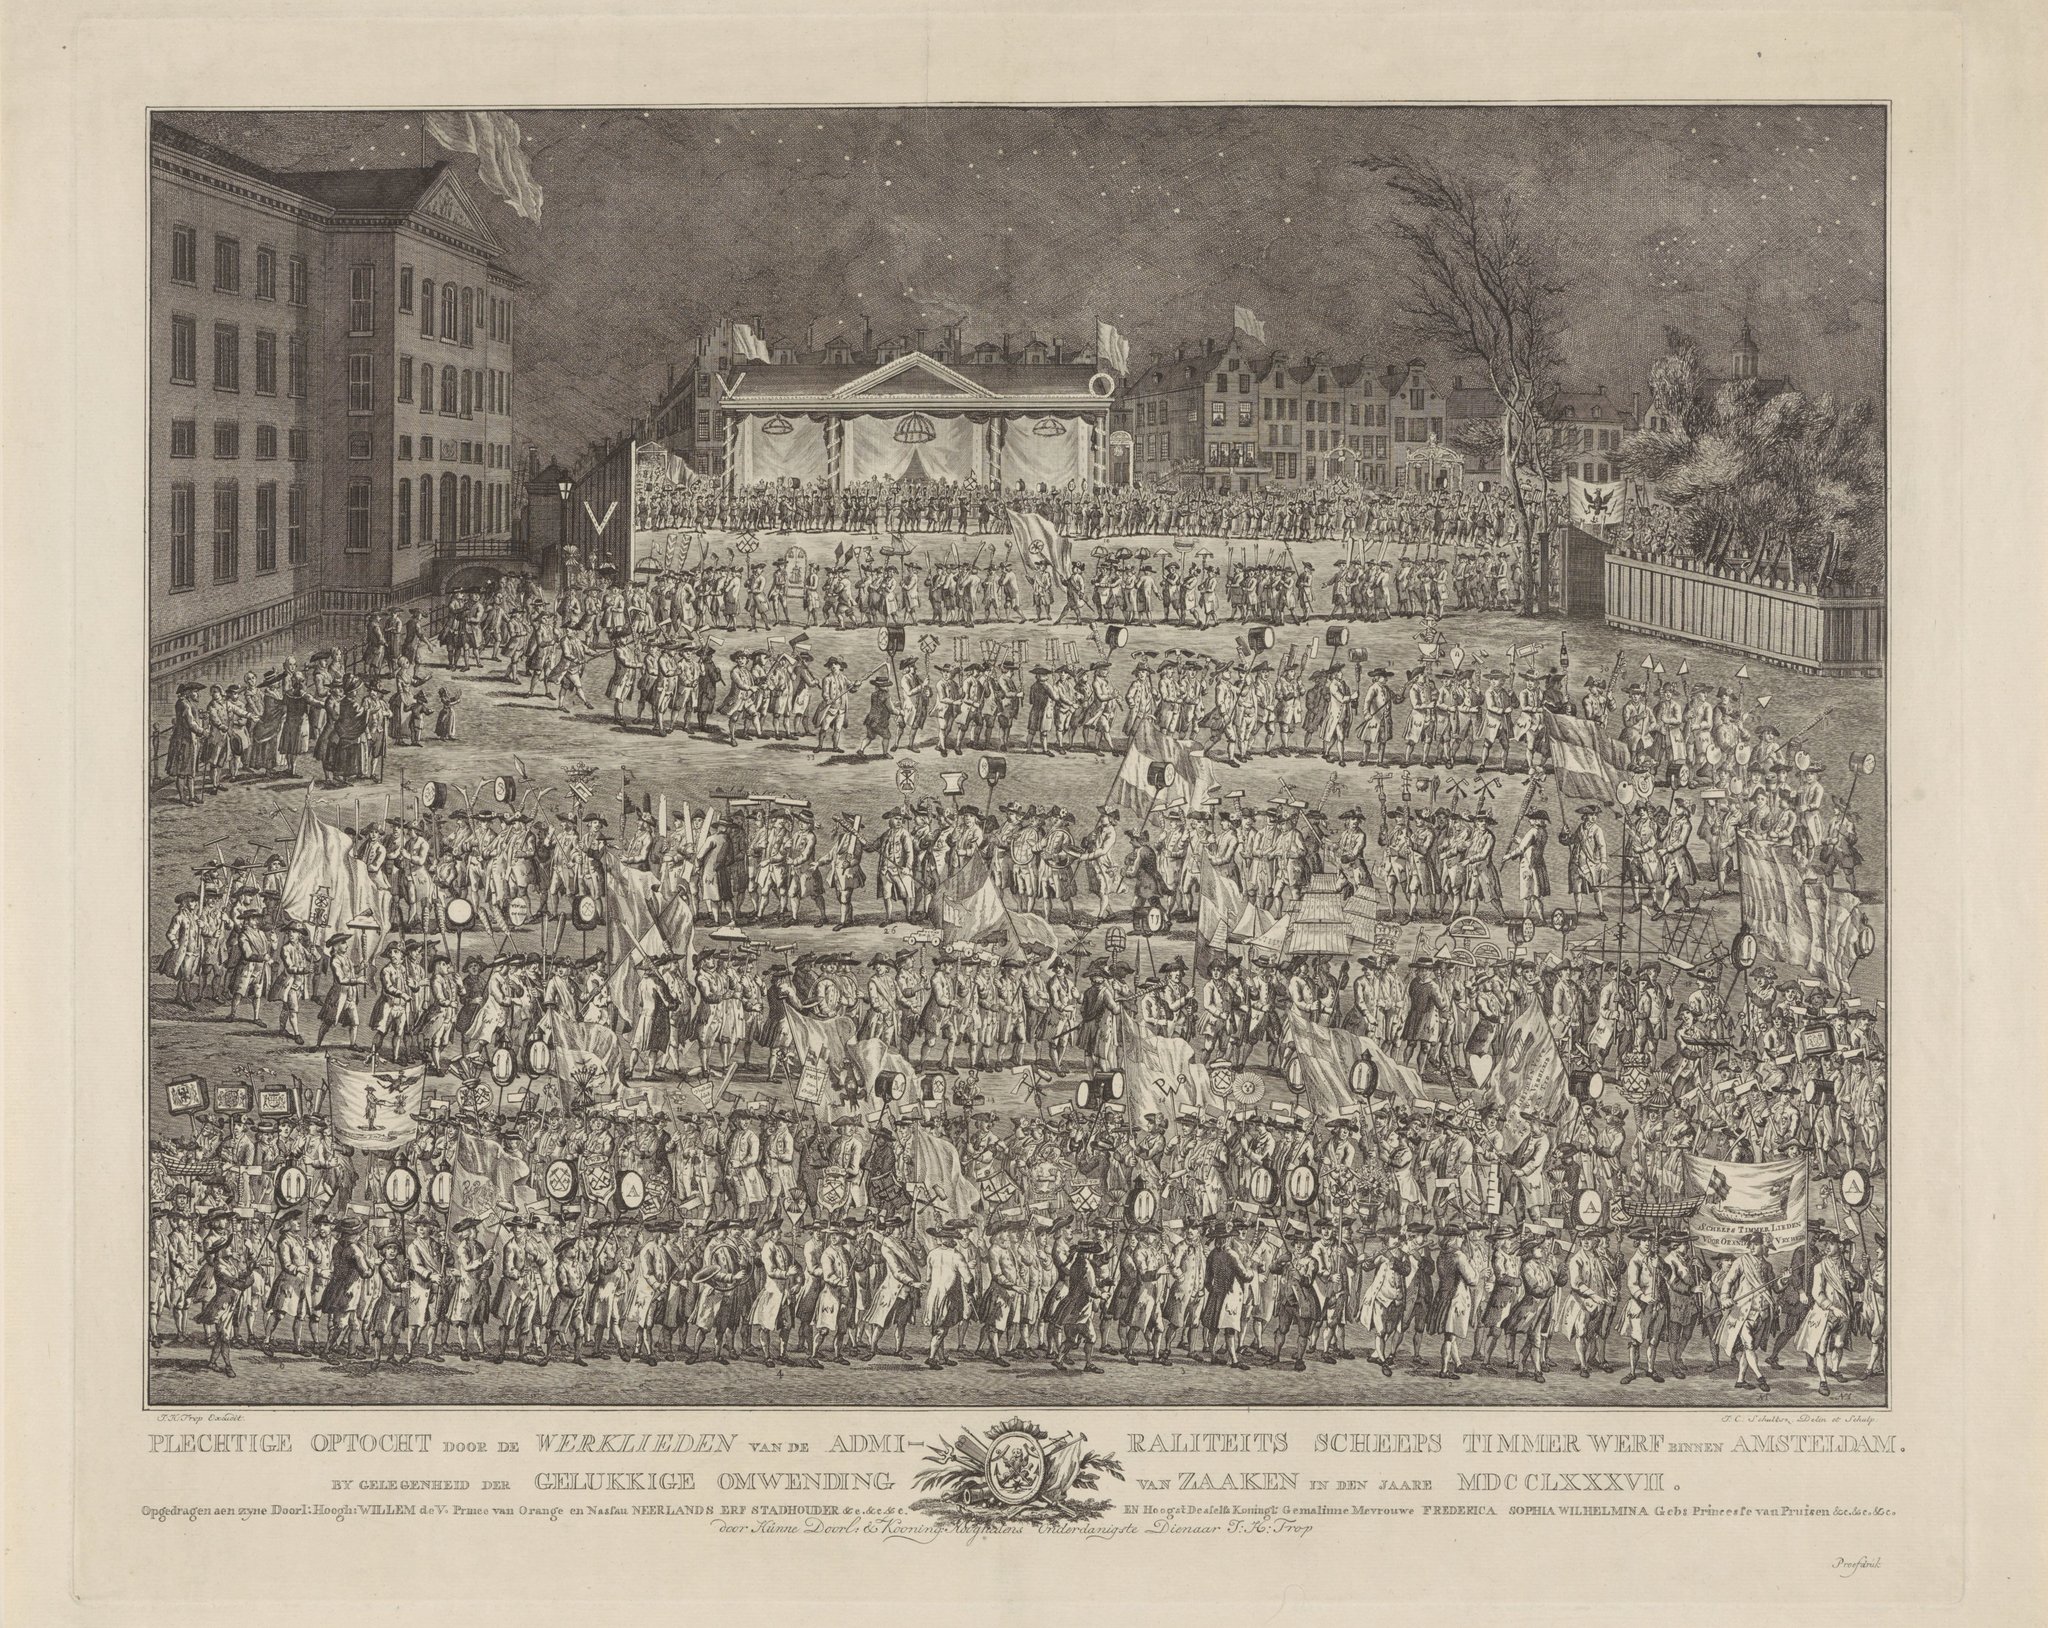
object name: print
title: Optocht van werklieden van de Admiraliteits Scheepstimmerwerf op het Kattenburgerplein te Amsterdam, 1787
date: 1787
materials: paper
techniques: engraving, etching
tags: the hague, william v (prince of orange), pageant of a guild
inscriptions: collector's mark: Lugt 2228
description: Feestelijke optocht in de avond van de Oranjegezinde werklieden van de Admiraliteits Scheepstimmerwerf, in de maanden oktober, november en december 1787. Lange stoet slingert zich over het Kattenburgerplein, links 's Lands Zeemagazijn. De werklieden dragen bijlen en andere werktuigen, borden met de naam van prins Willem V, vlaggen, insignes en symbolen en lantaarns met kaarsen.